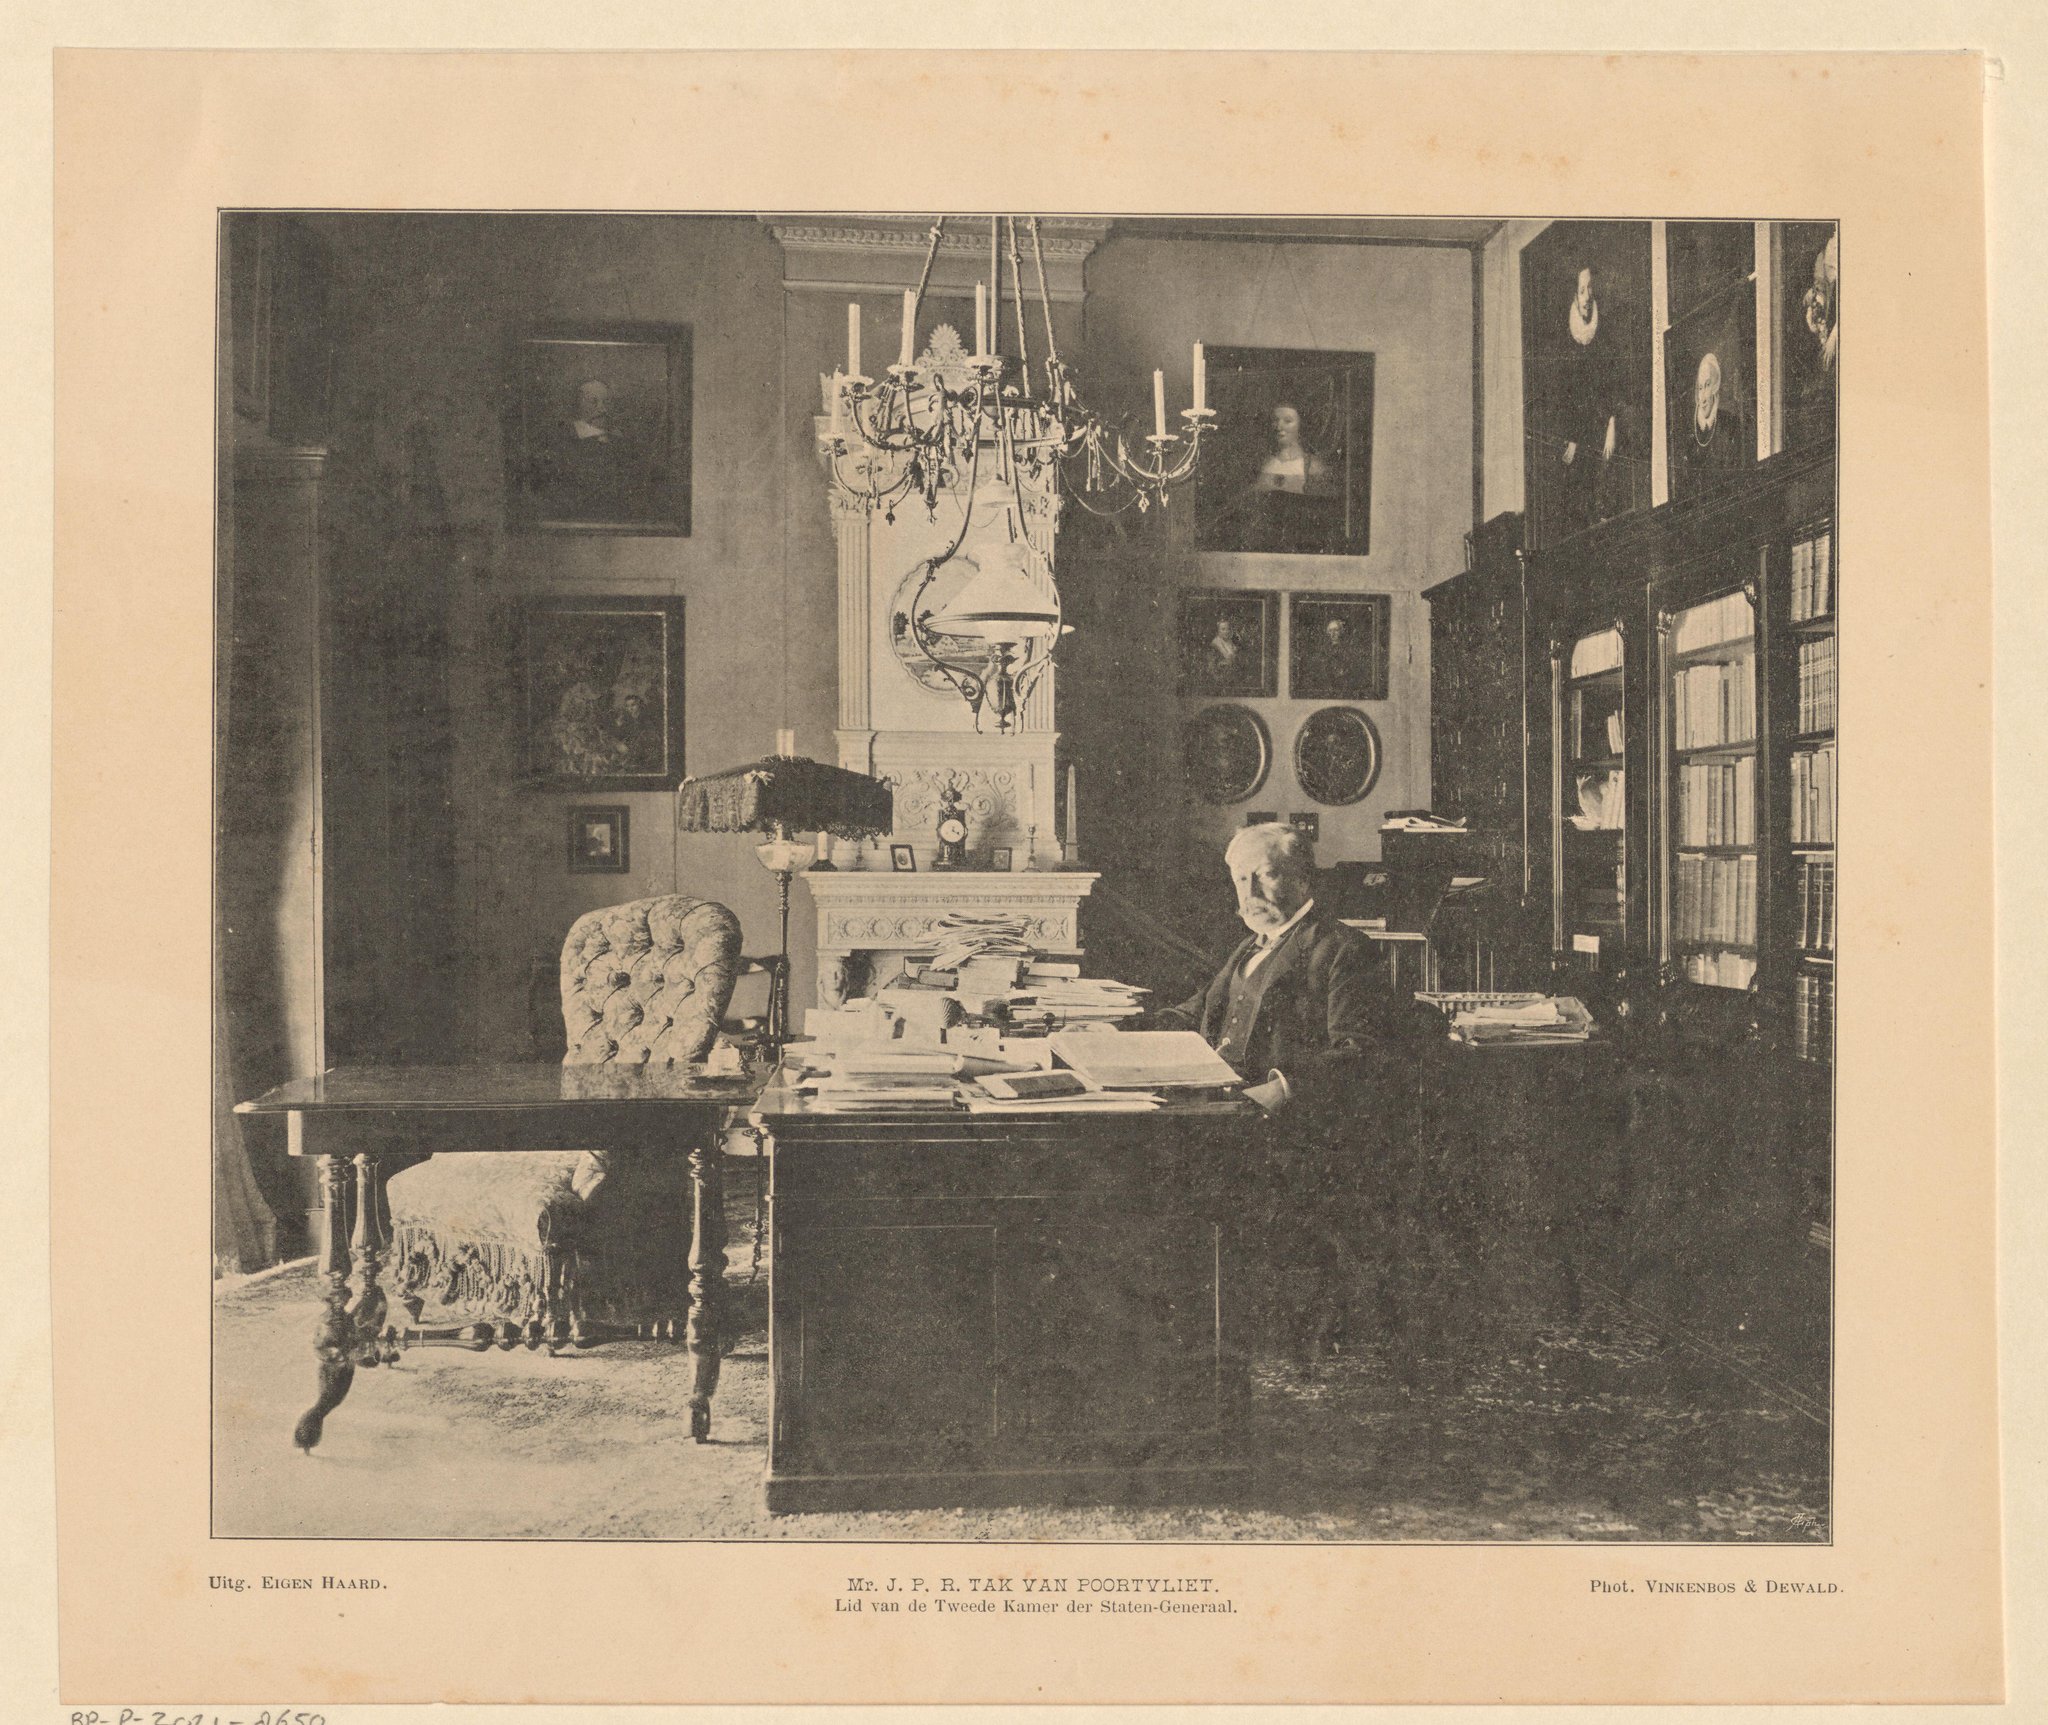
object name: photomechanical print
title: Johannes Pieter Roetert Tak van Poortvliet in zijn werkkamer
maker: Anonymous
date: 1895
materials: paper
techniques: autotype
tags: the hague, politician, historical persons, politician, e.g. party leader